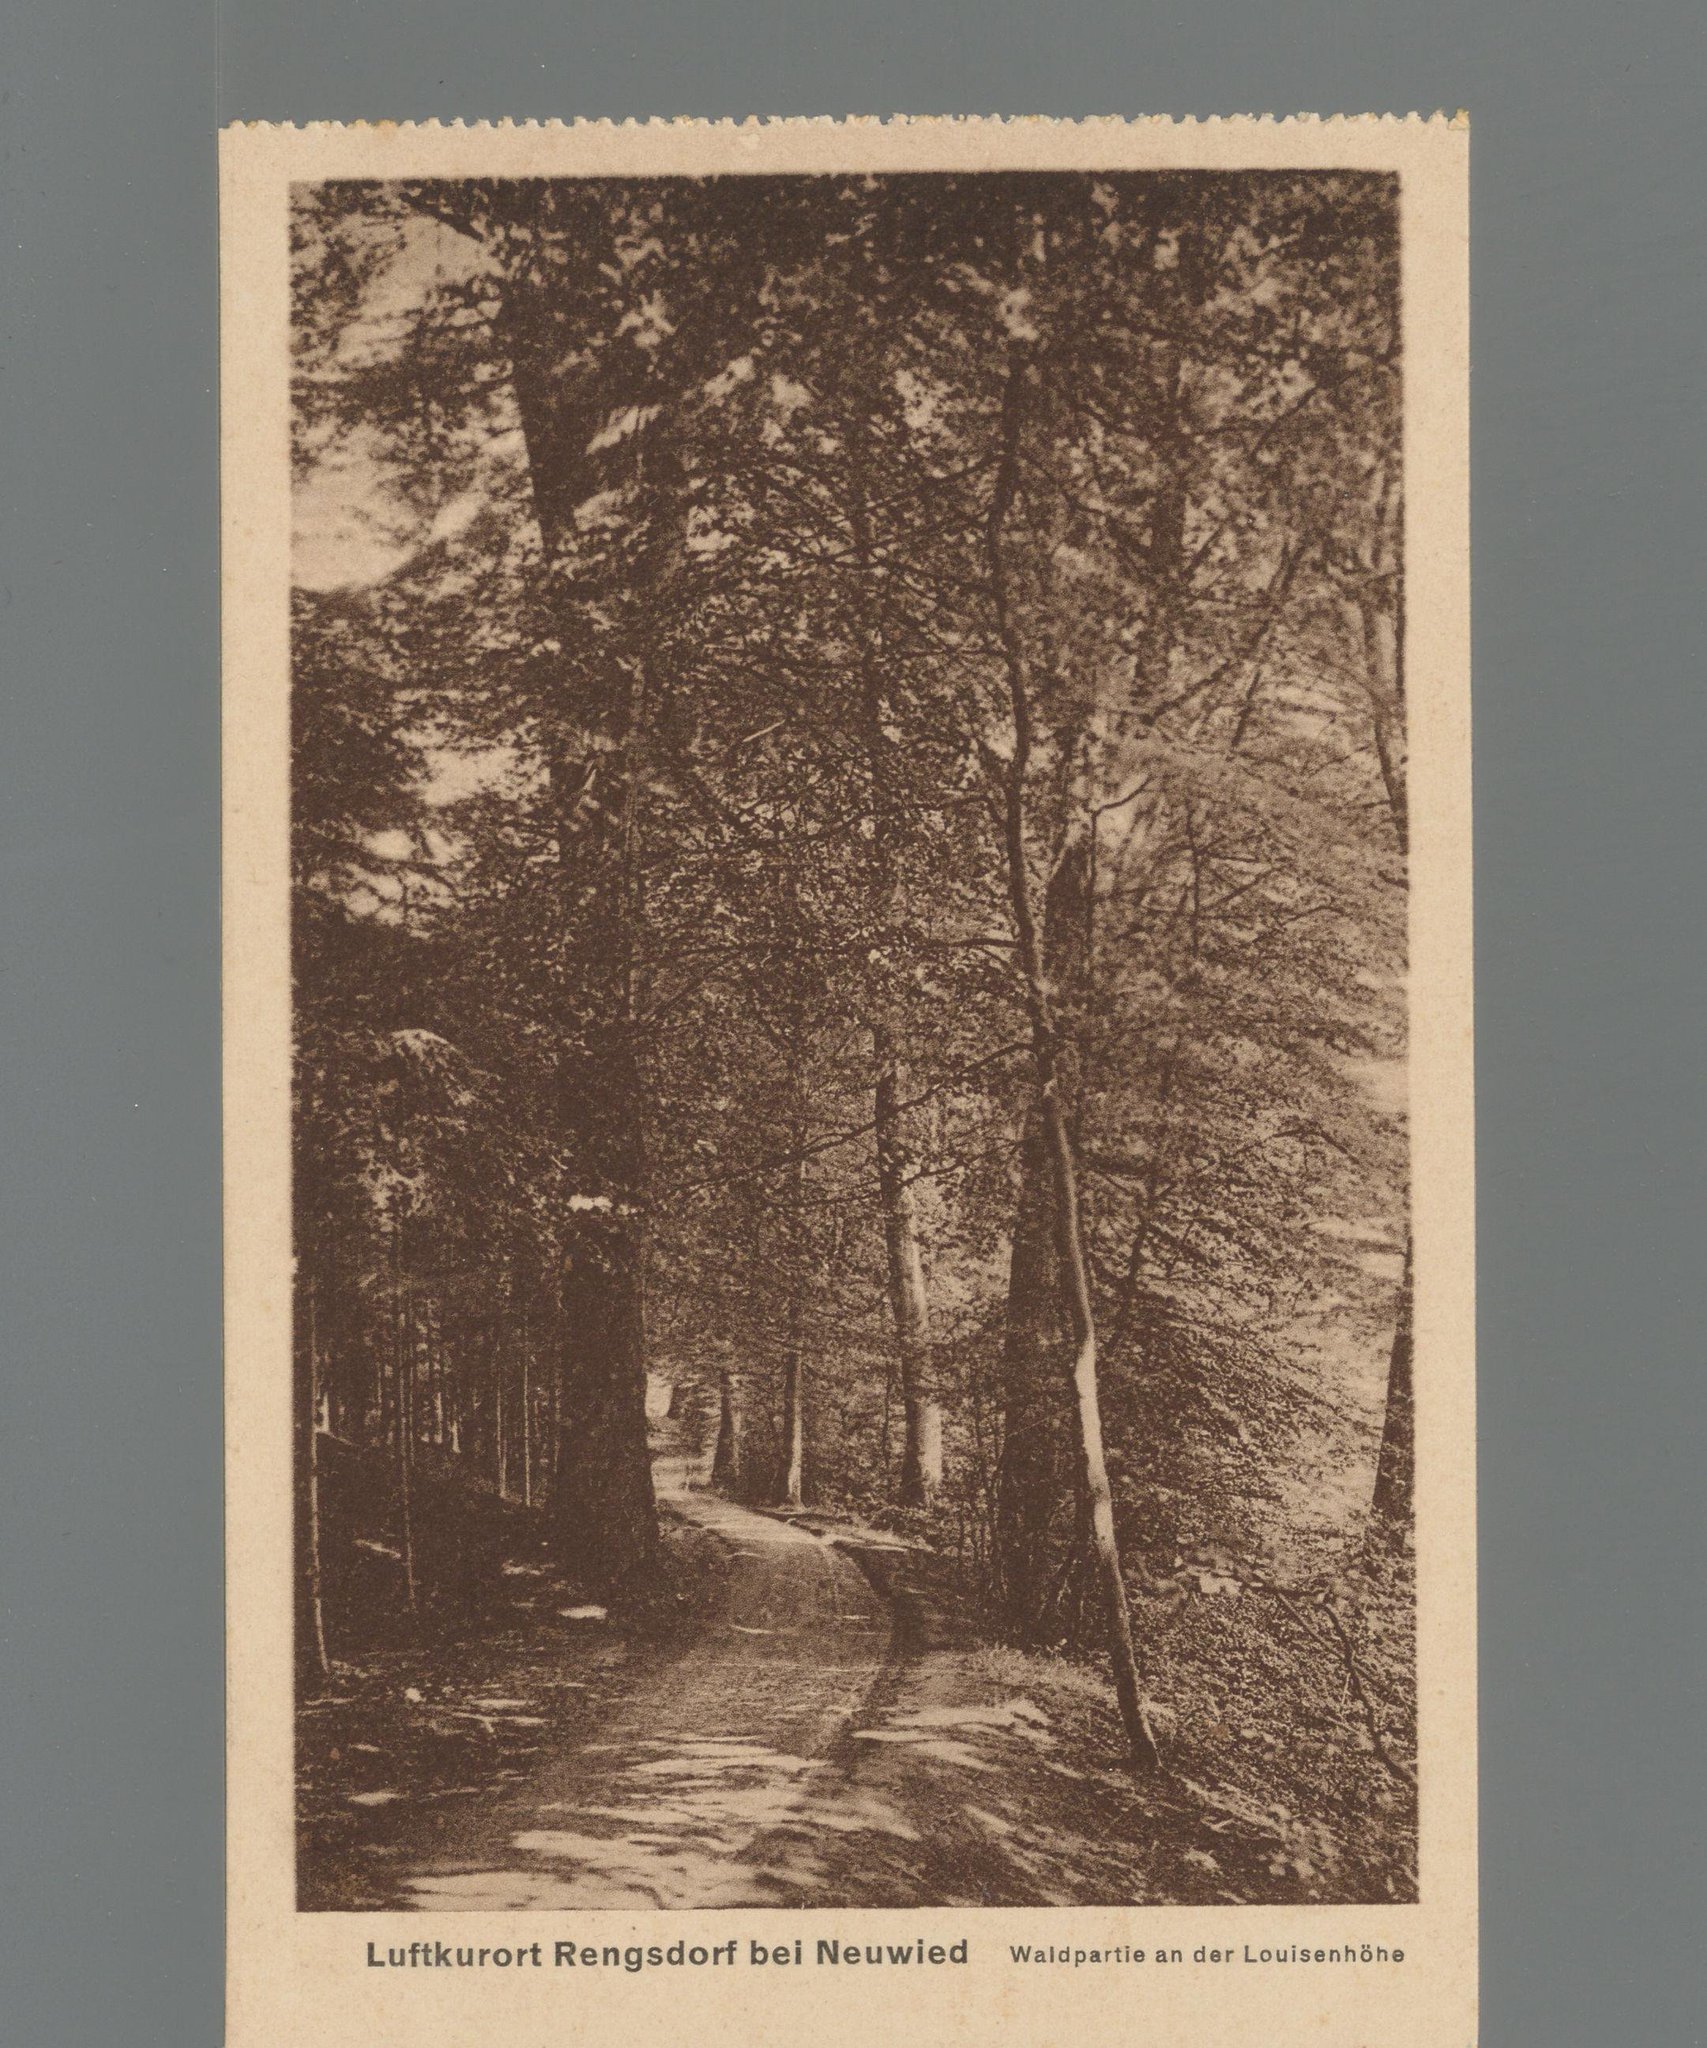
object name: ansichtkaart, prentbriefkaart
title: Luftkurort Rengsdorf bei Neuwied. Waldpartie an der Louisenhöhe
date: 1905-1930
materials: cardboard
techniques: photograph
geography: rengsdorf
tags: forest path or lane, mountains